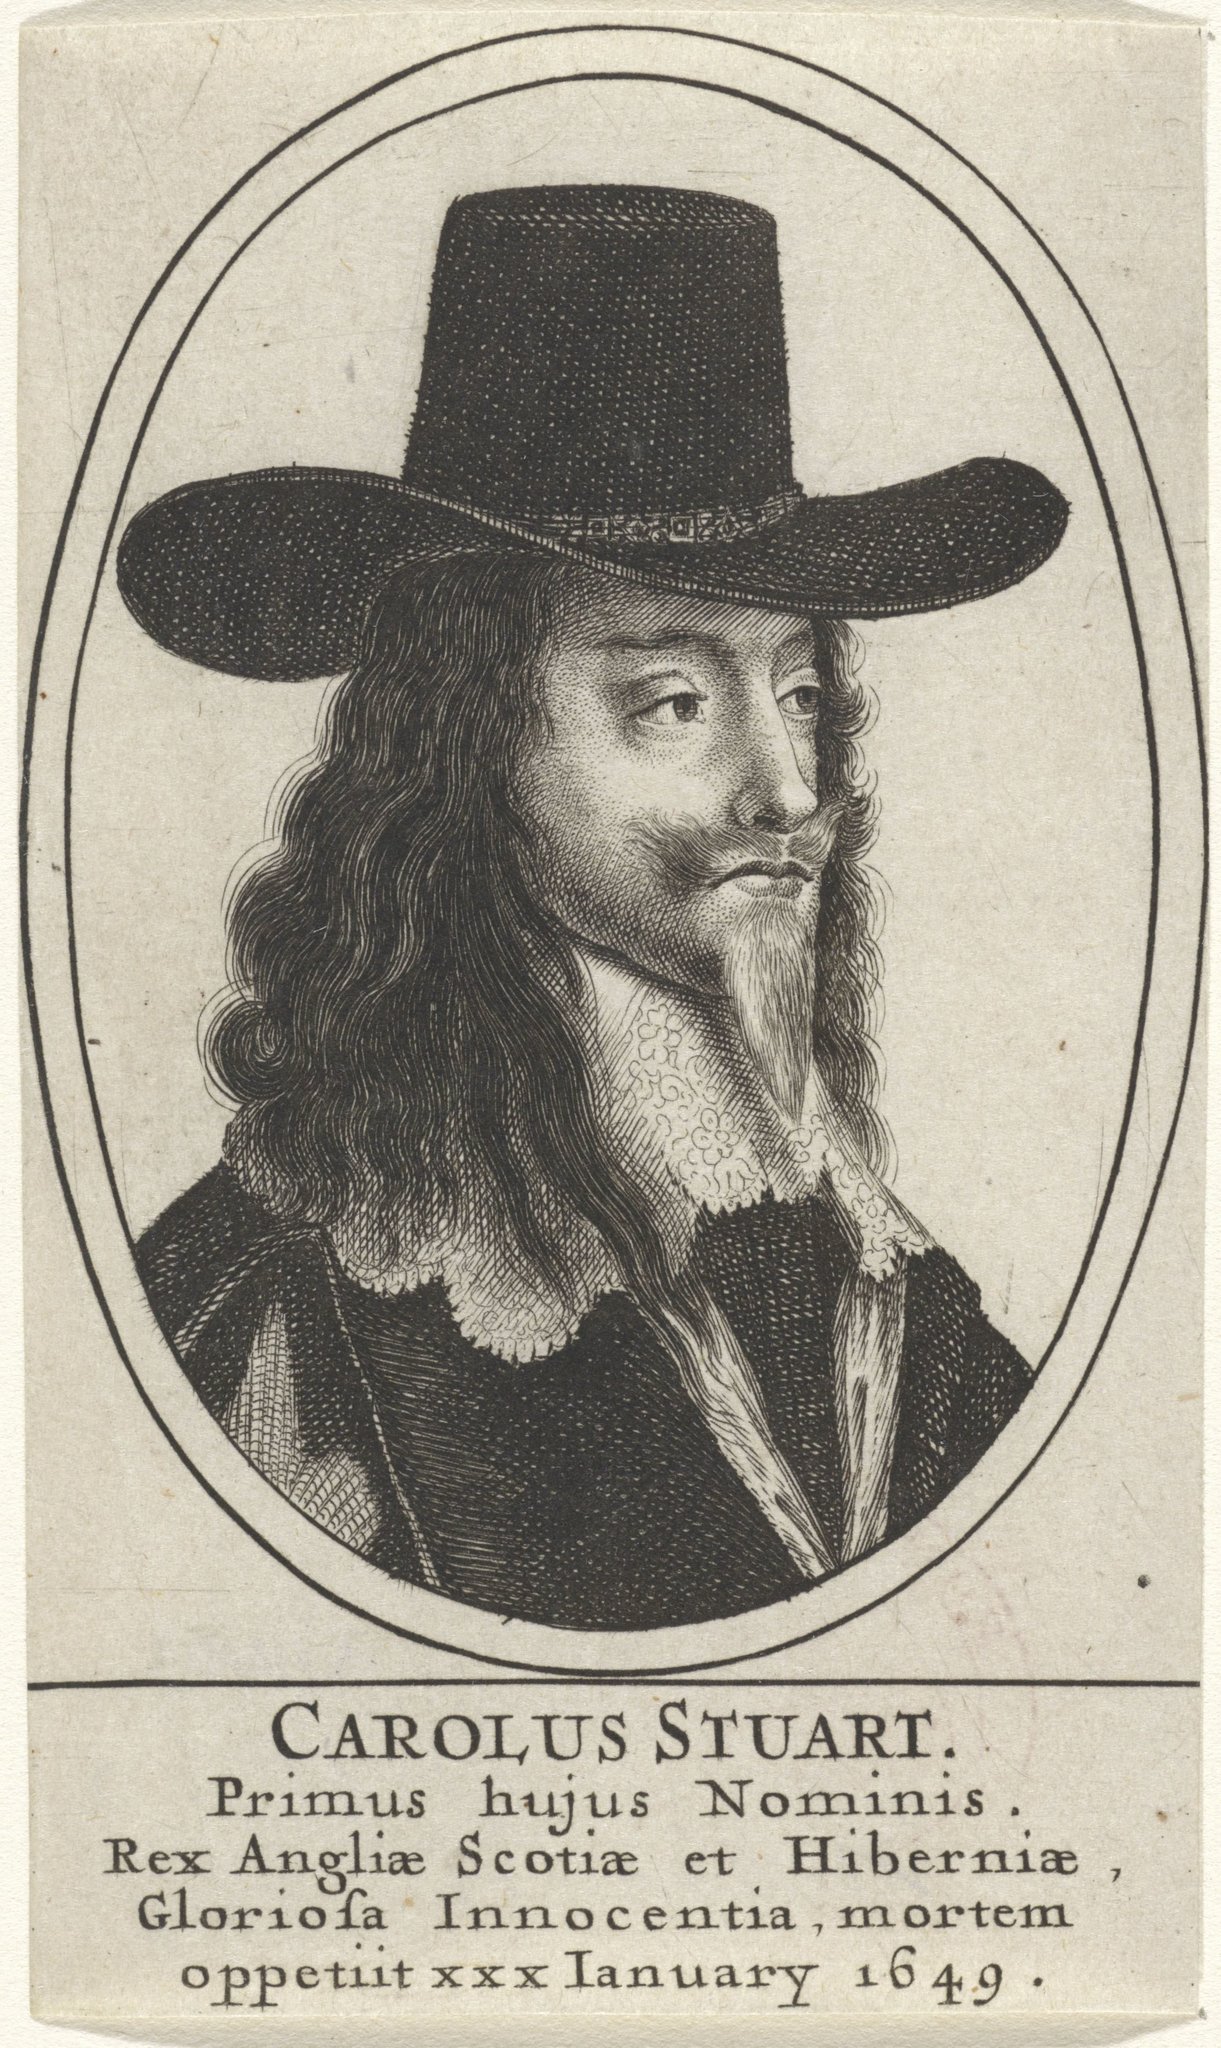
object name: print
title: Portret van Karel I, koning van Engeland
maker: Anonymous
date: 1649-1727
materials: paper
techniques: etching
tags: karel i (koning van engeland), head-gear: hat (+ men's clothes)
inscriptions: collector's mark: Lugt 240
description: Vgl. New Holstein German (Hollar) 1062 en Pennington 1432.